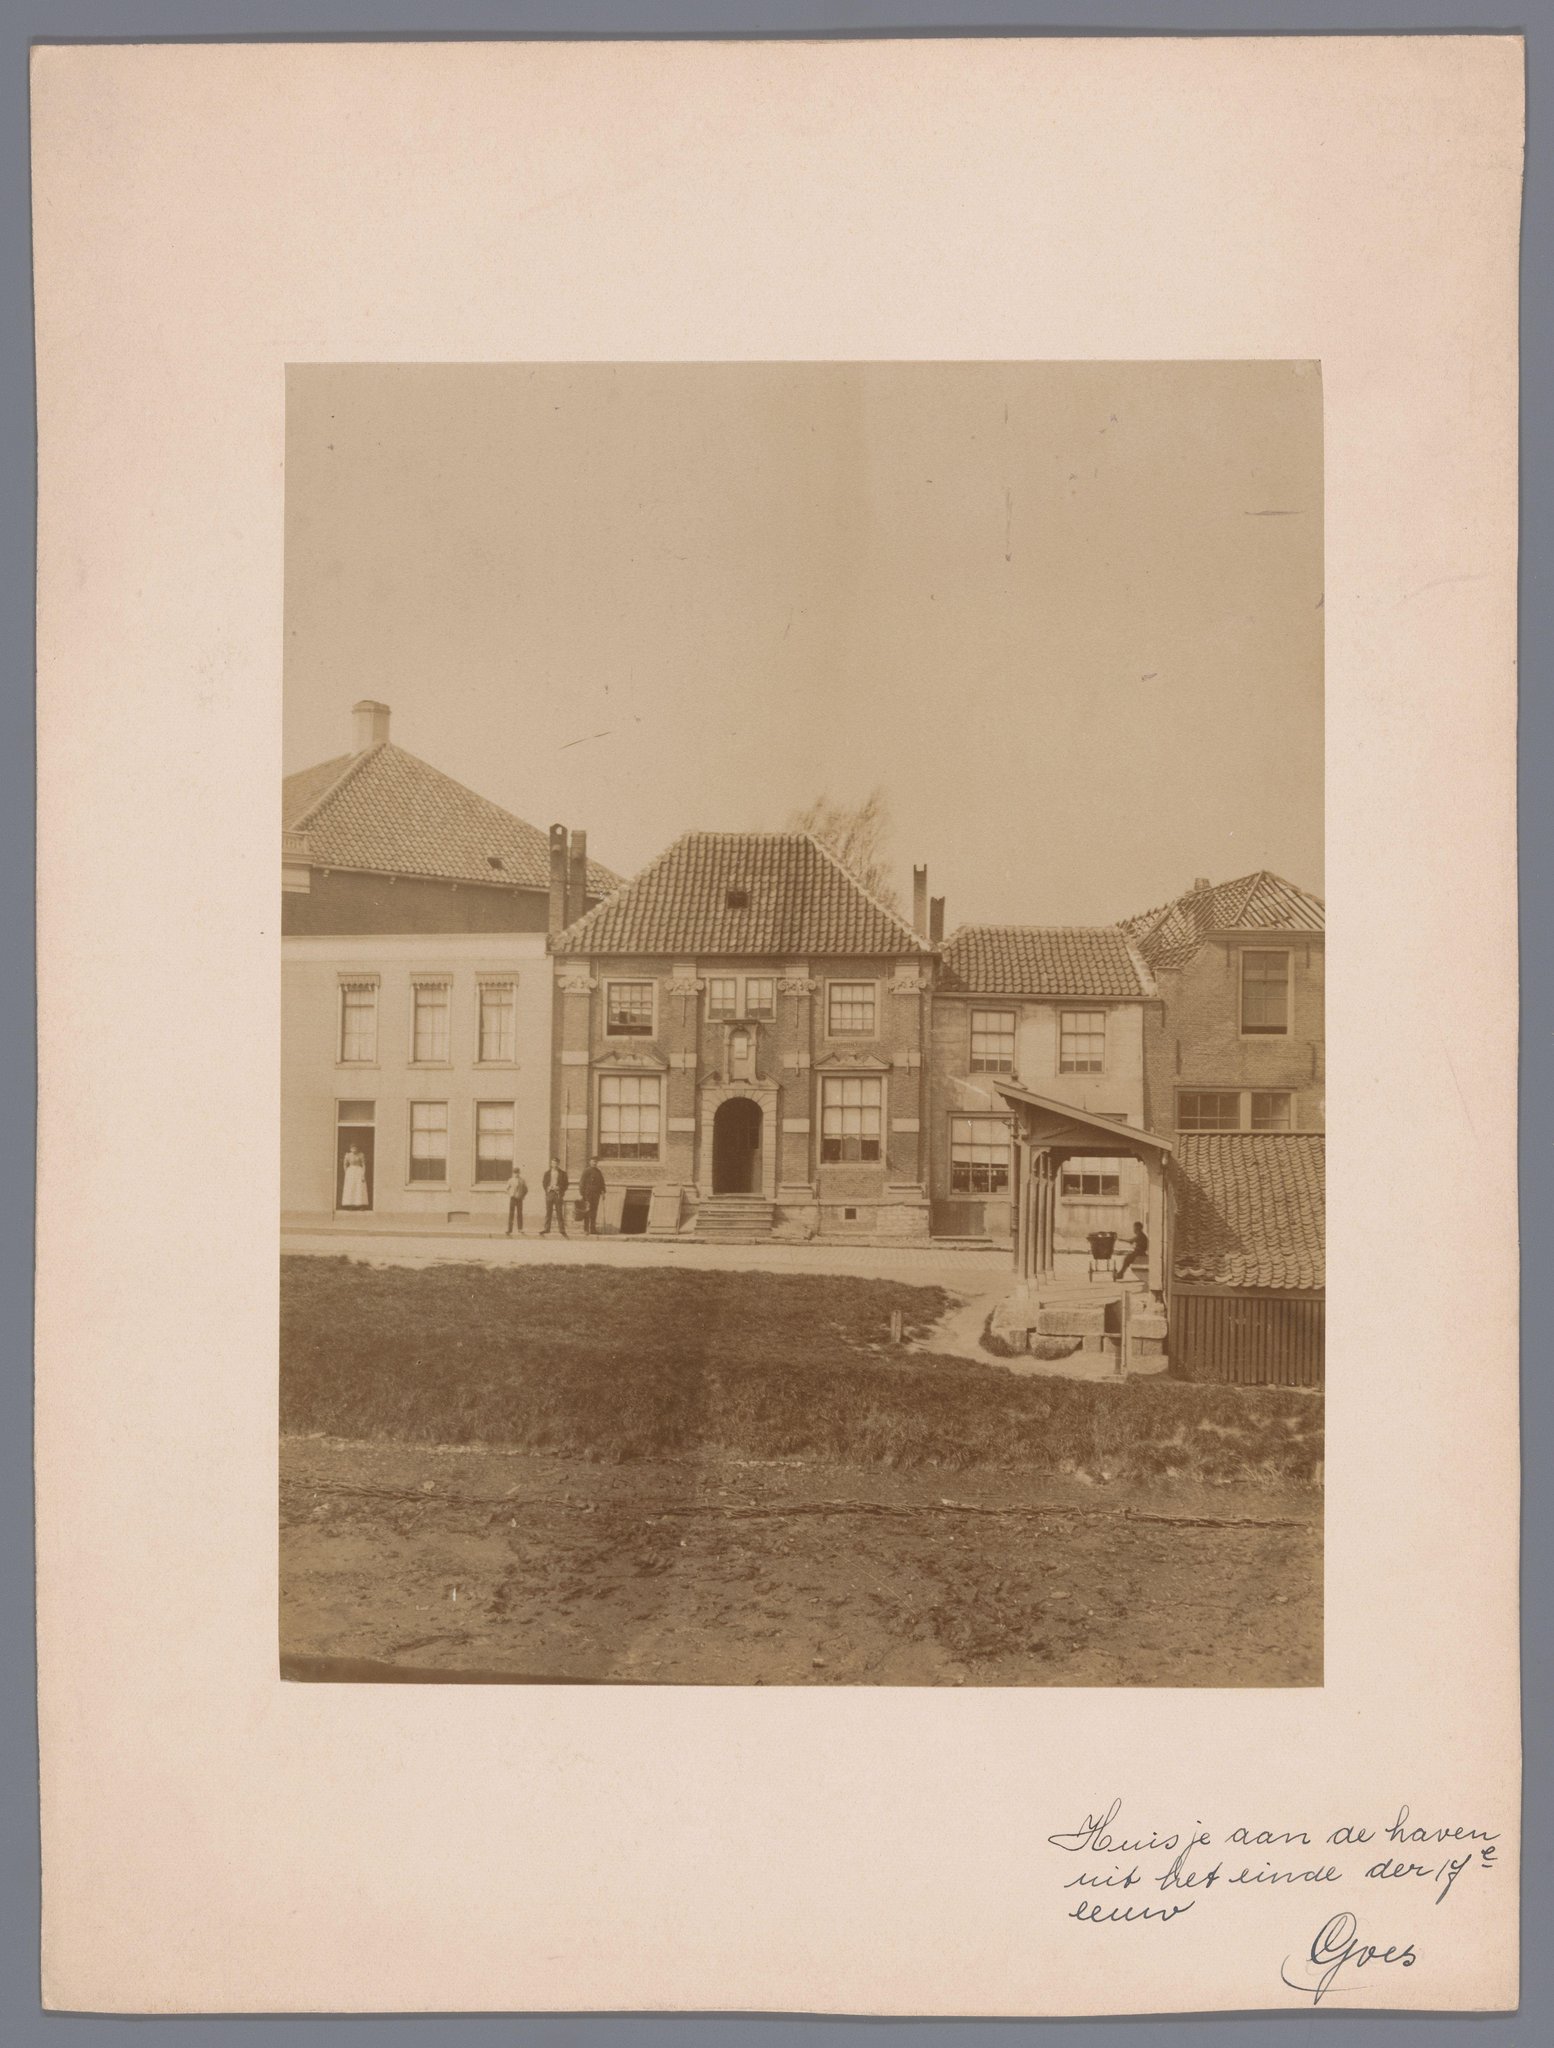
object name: photograph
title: Huizen aan de haven in Goes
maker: anoniem (monumentenzorg)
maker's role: fotograaf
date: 1890-1920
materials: cardboard, photographic support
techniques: albumen print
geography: goes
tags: urban housing, street (+ city(-scape) with figures, staffage)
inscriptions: annotation: ‘Huisje aan de haven uit het einde der 17e eeuw/ Goes’, annotation: ‘Goes (Z.)/ Huisje uit het einde der 17de eeuw aan de haven’